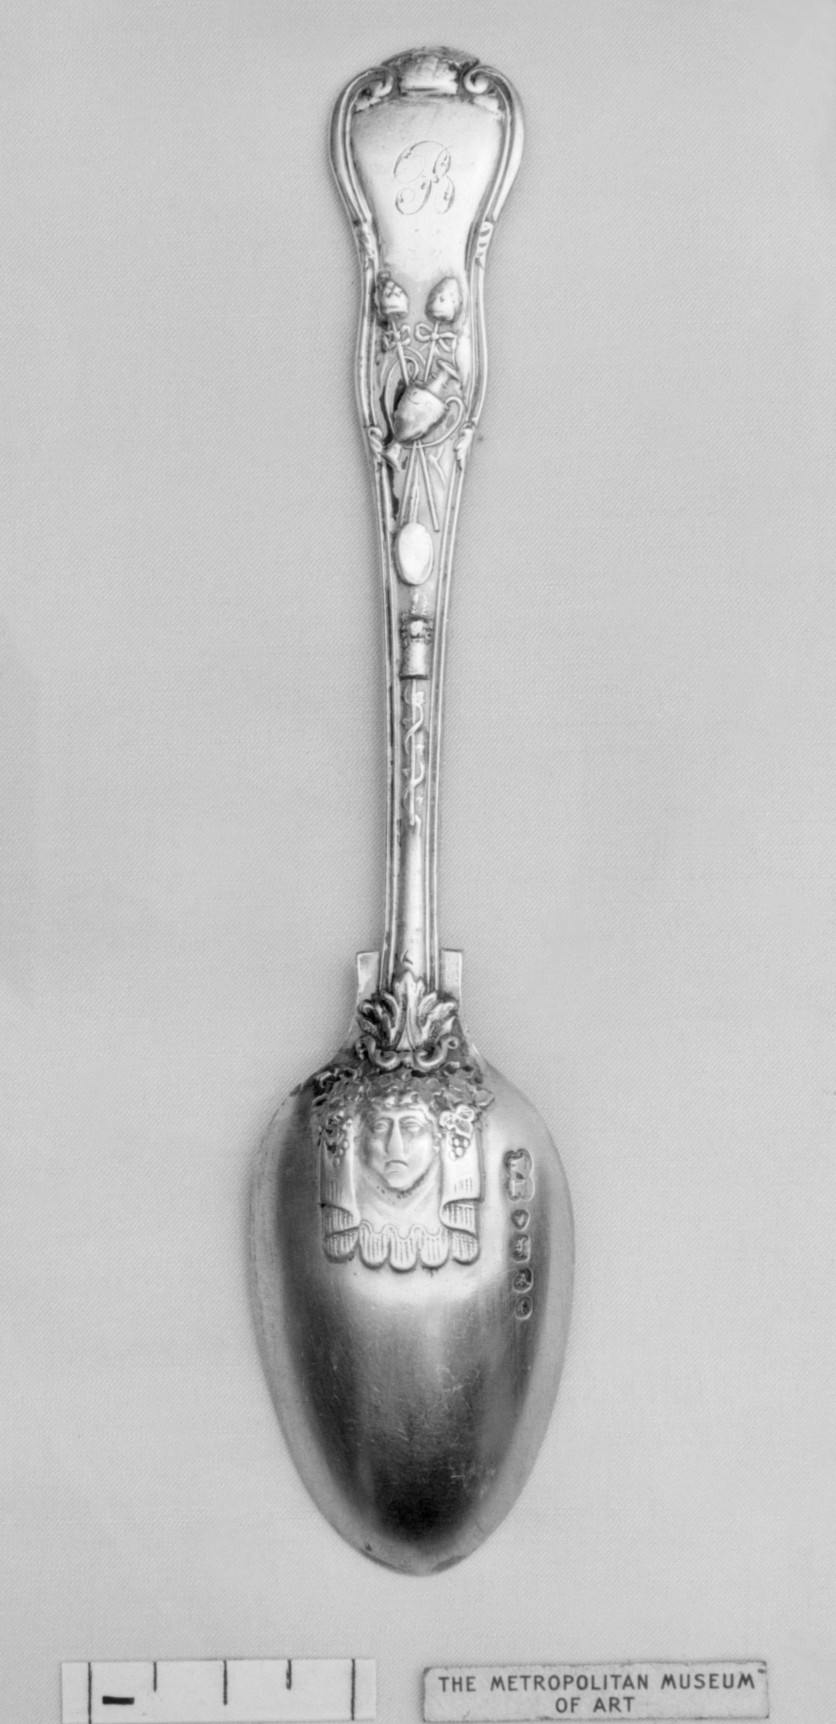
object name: teaspoon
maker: w. k. (?)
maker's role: maker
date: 1836-1837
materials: silver